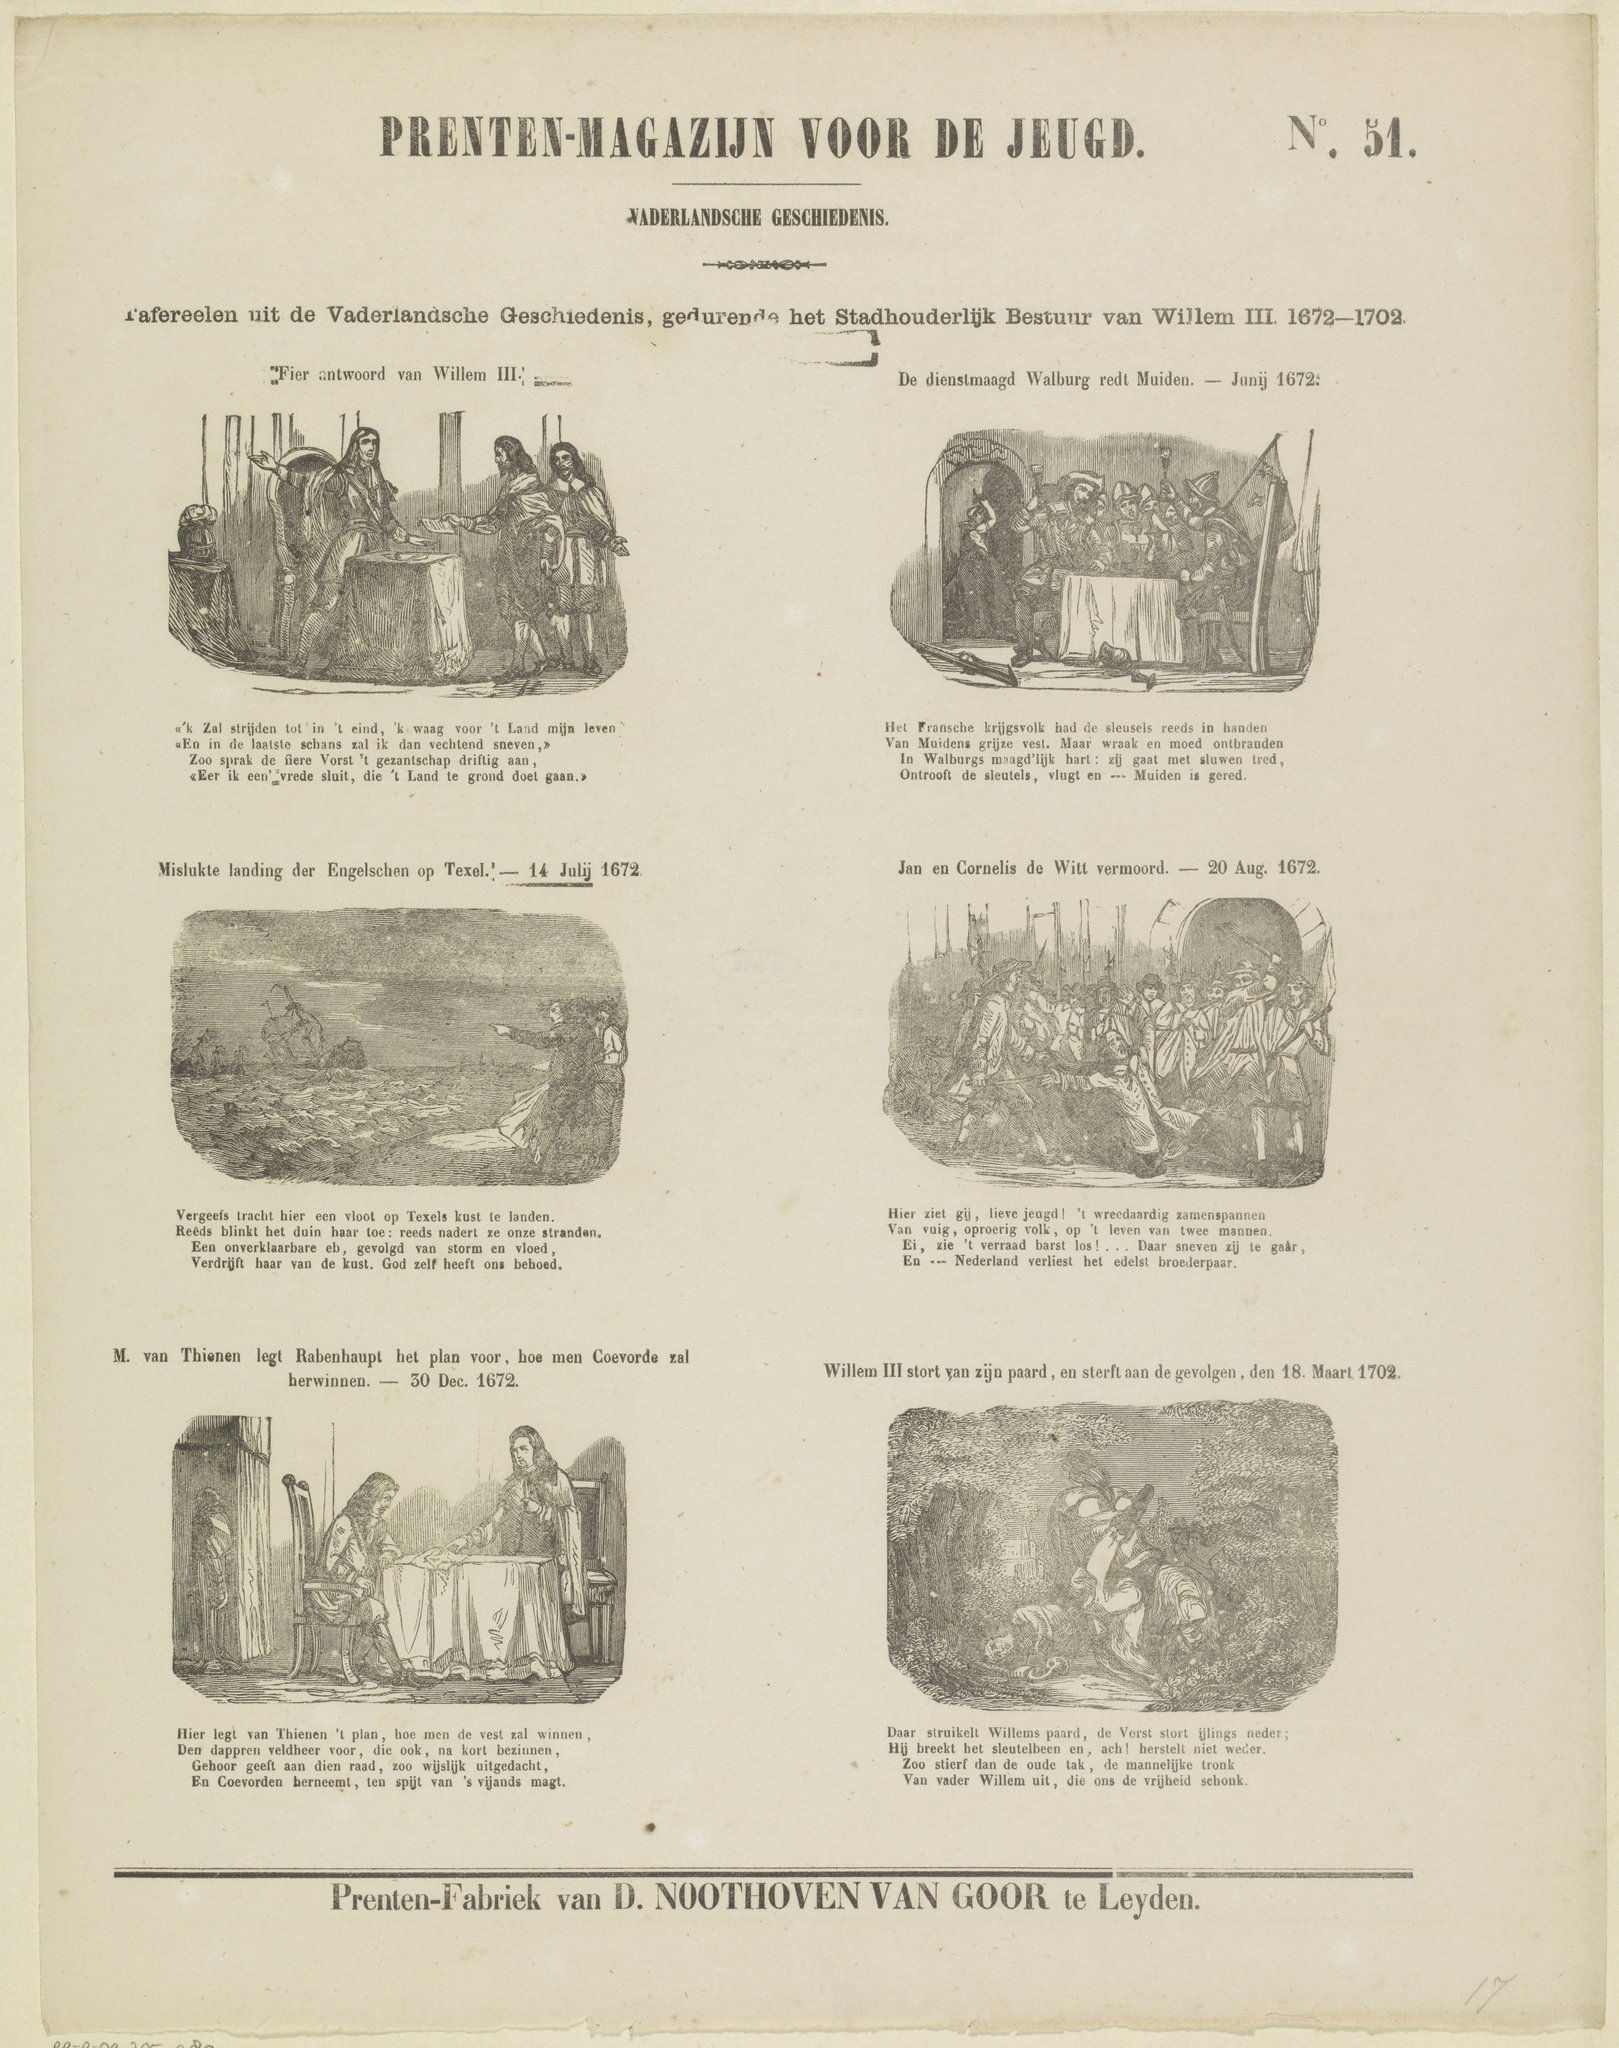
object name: print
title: Tafereelen uit de vaderlandsche geschiedenis, gedurende het stadhouderlijk bestuur van Willem III 1672-1702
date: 1850-1881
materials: paper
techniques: letterpress printing, engraving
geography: netherlands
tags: cornelis de witt, william iii (prince of orange and king of england, scotland, and ireland), amsterdam, france, history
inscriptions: collector's mark: Lugt 2228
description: Blad met 6 voorstellingen over het leven van Willem III, tijdens zijn periode als stadhouder tussen 1672 en 1702. Boven elke voorstelling een titel en onder elke voorstelling een vierregelig vers. Genummerd rechtsboven: No. 51.